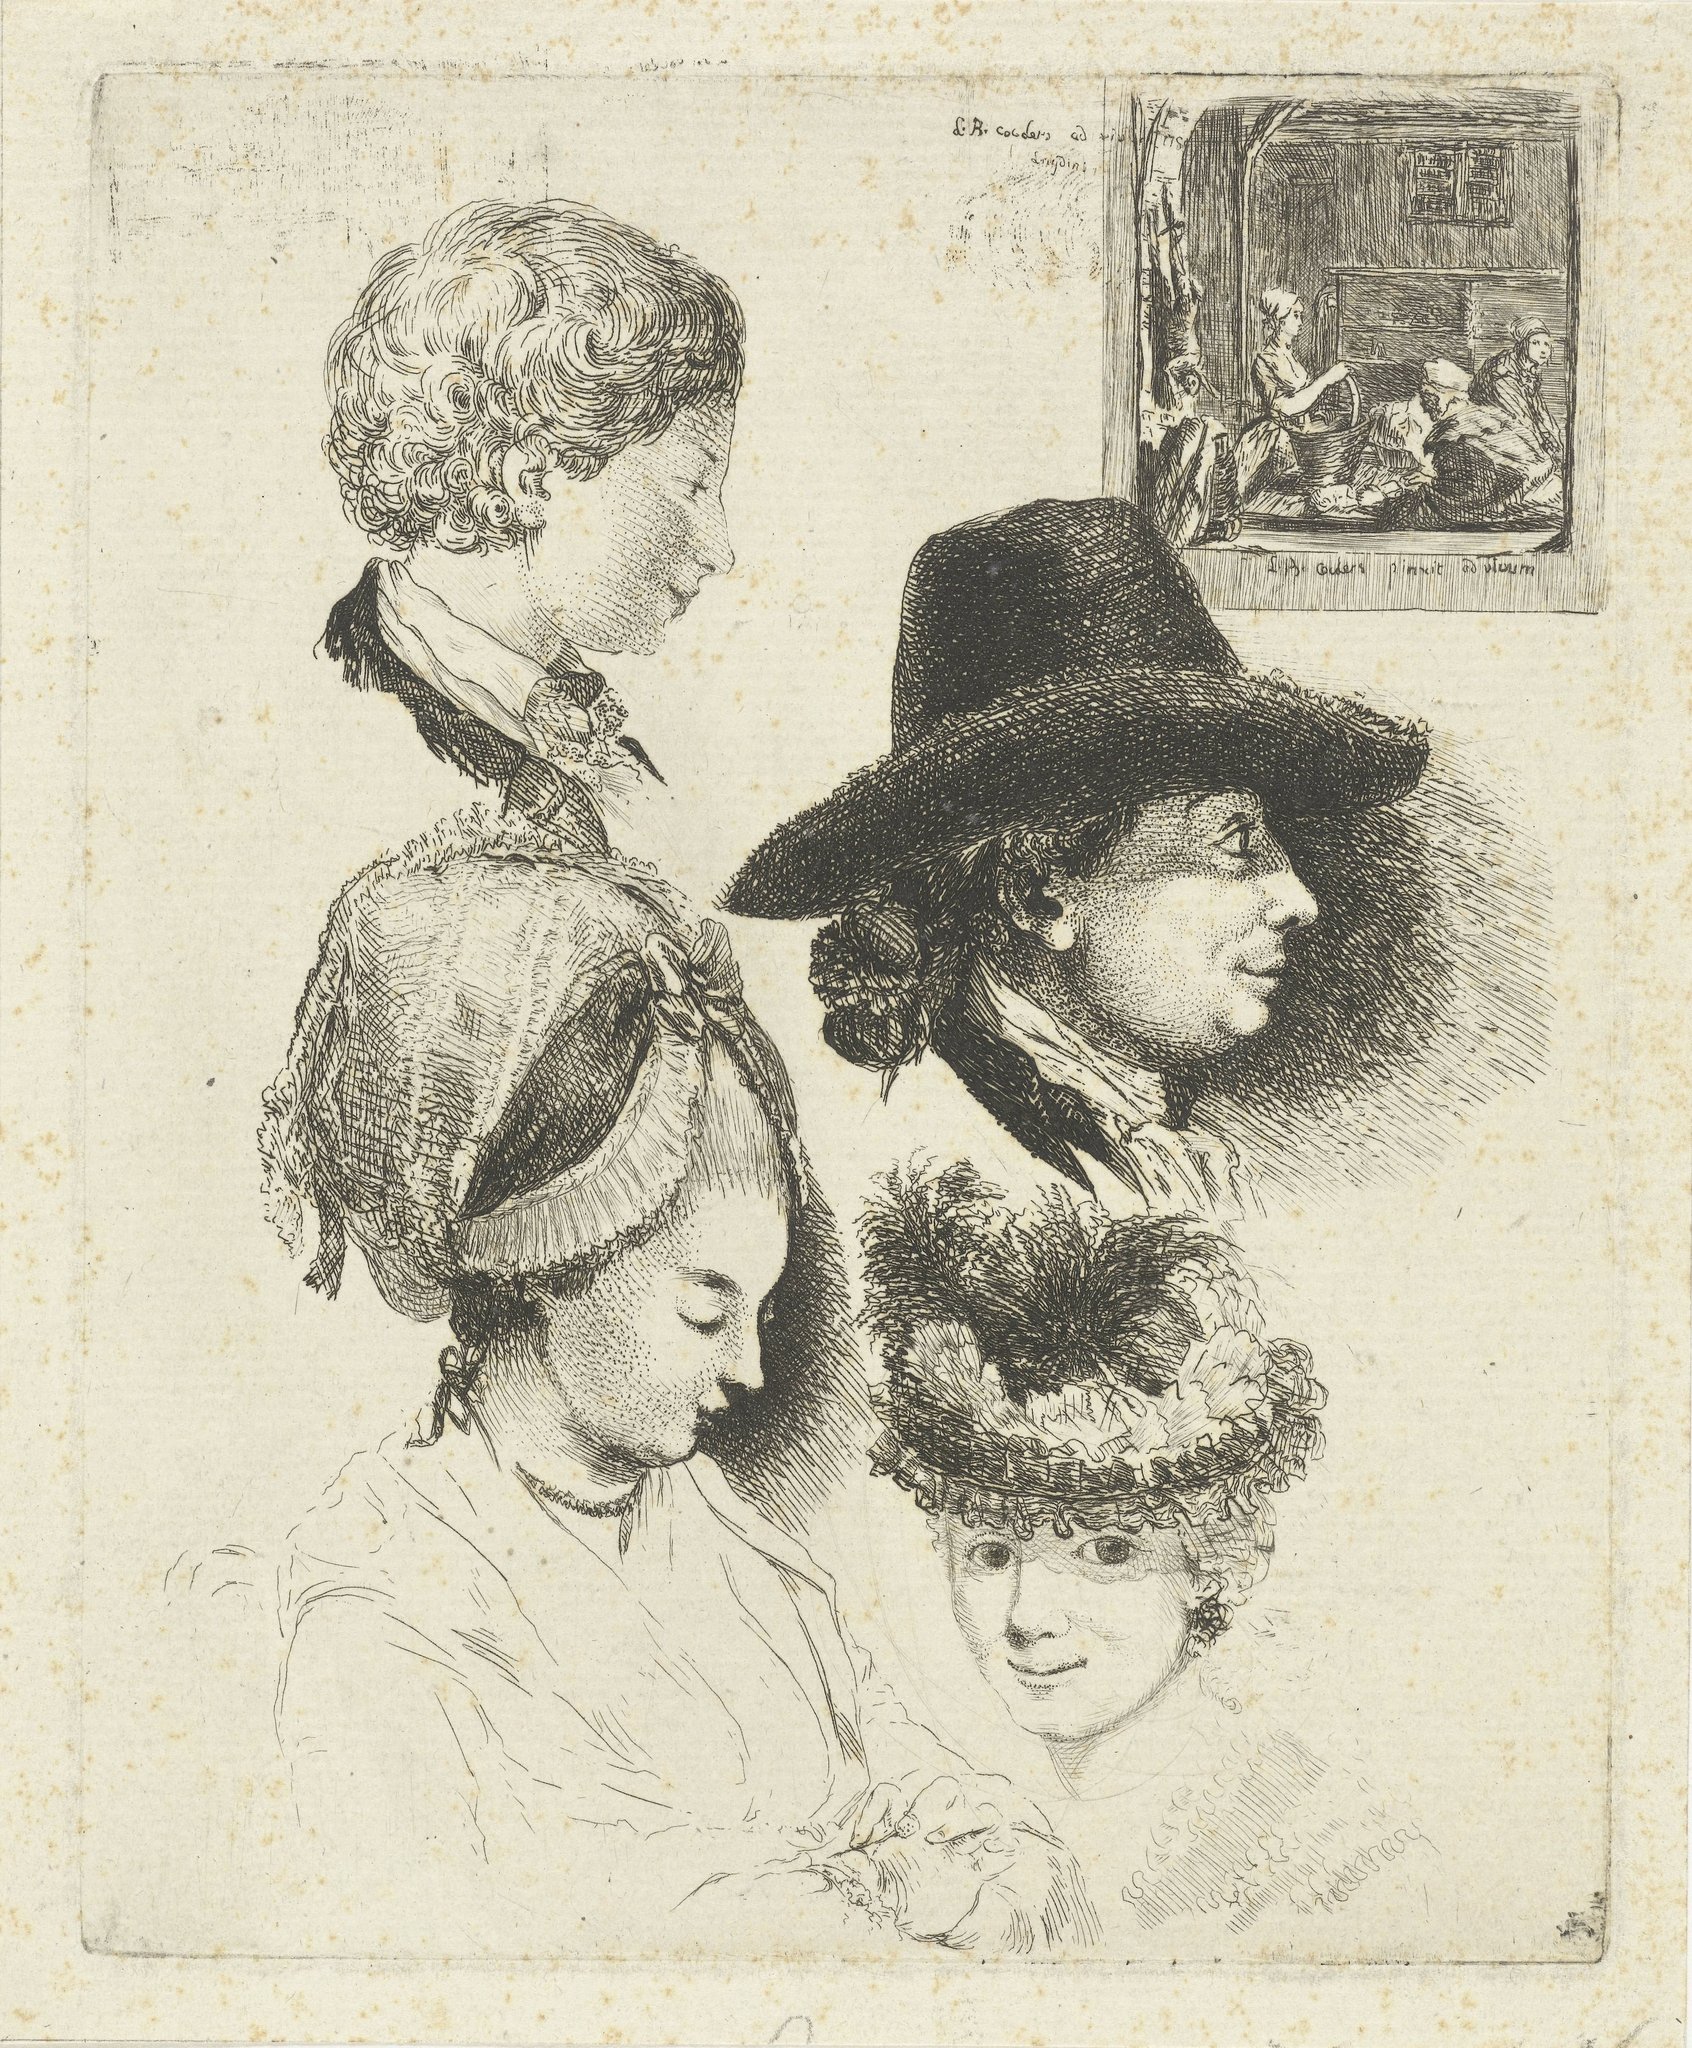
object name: print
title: Studieblad met portretten van Louis Bernard Coclers en zijn familie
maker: louis bernard coclers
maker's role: draughtsman, print maker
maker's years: 1741-1817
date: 1780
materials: paper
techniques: etching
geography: leiden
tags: conservator, marie lambertine coclers, liège, print maker, draughtsman, louis bernard coclers, print, e.g.: engraving, etching, lithograph, the artist and his family, relatives, etc. (+ portrait, self-portrait of artist)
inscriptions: collector's mark: Lugt 2760, collector's mark: Lugt 2166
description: Portretbuste van Louis Bernard Coclers met zwarte hoed, naar rechts. Portretbuste van zijn zoon, linksboven, en zijn nichtje, linksonder. Rechtsonder een portretbuste van zijn zus met een pluimhoed. Rechtsboven een afbeelding van een door hem gemaakte prent met een poelierwinkel.